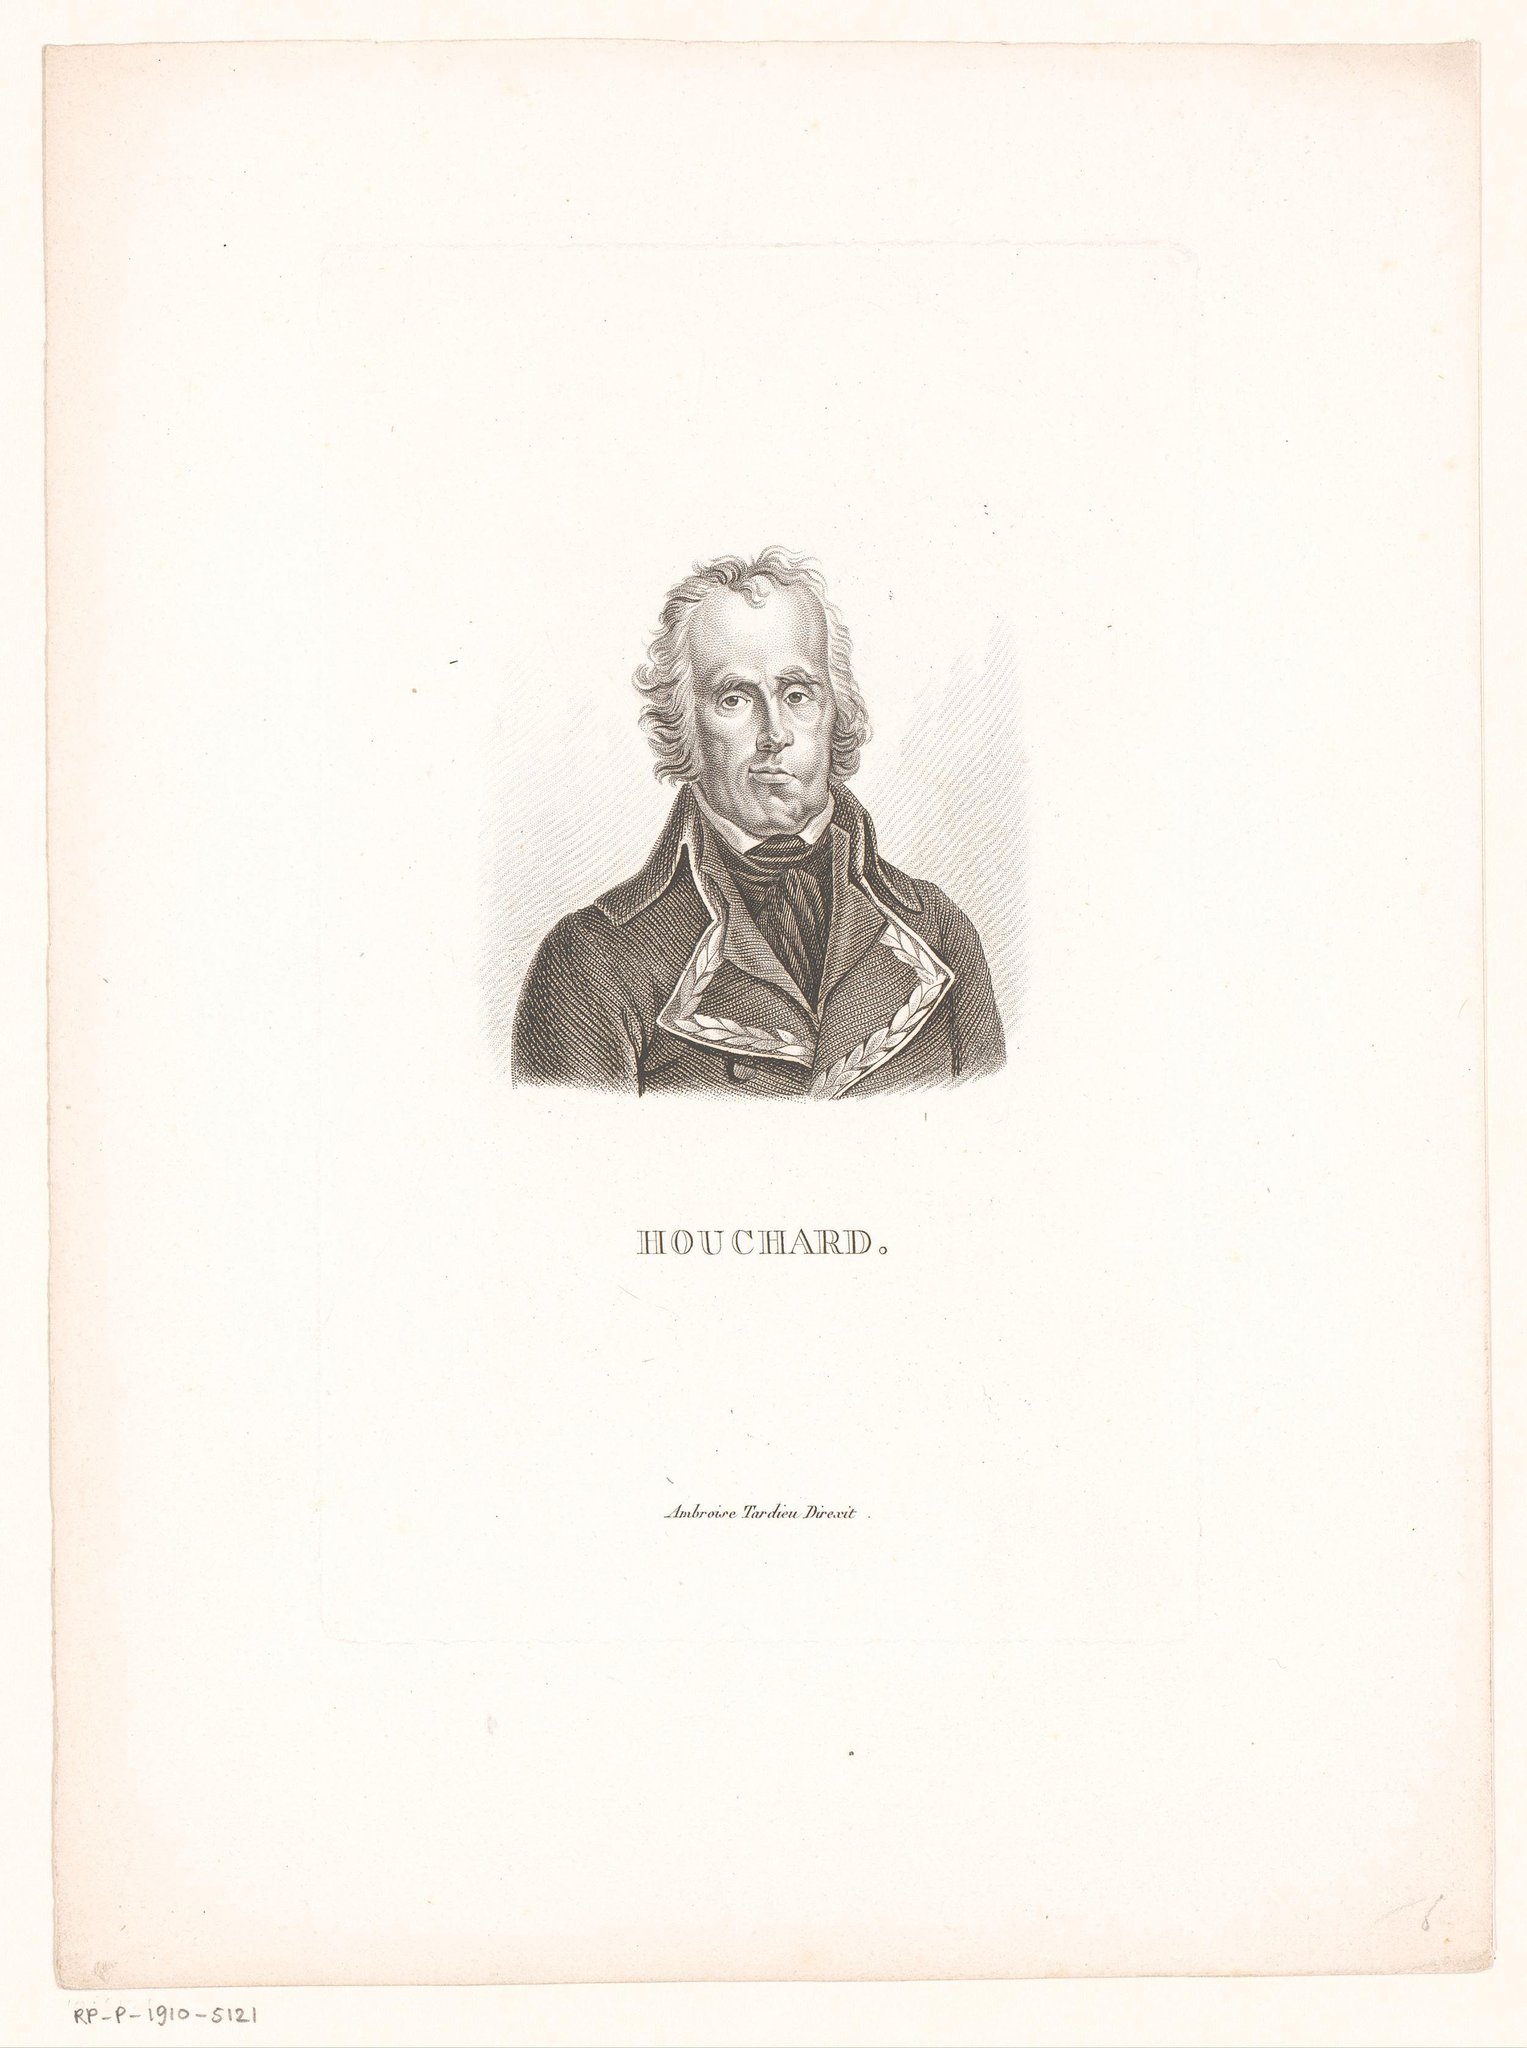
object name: print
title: Portret van Jean Nicolas Houchard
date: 1818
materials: paper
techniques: engraving, etching, roulette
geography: paris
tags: paris, commander-in-chief, general, marshal, historical persons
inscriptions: collector's mark: Lugt 2228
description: Mogelijk prent uit: Tardieu, Ambroise. Portraits des généraux français, faisant suite aux "Victoires et conquêtes des Français". Parijs: Panckoucke, Charles Louis Fleury, ca. 1818.